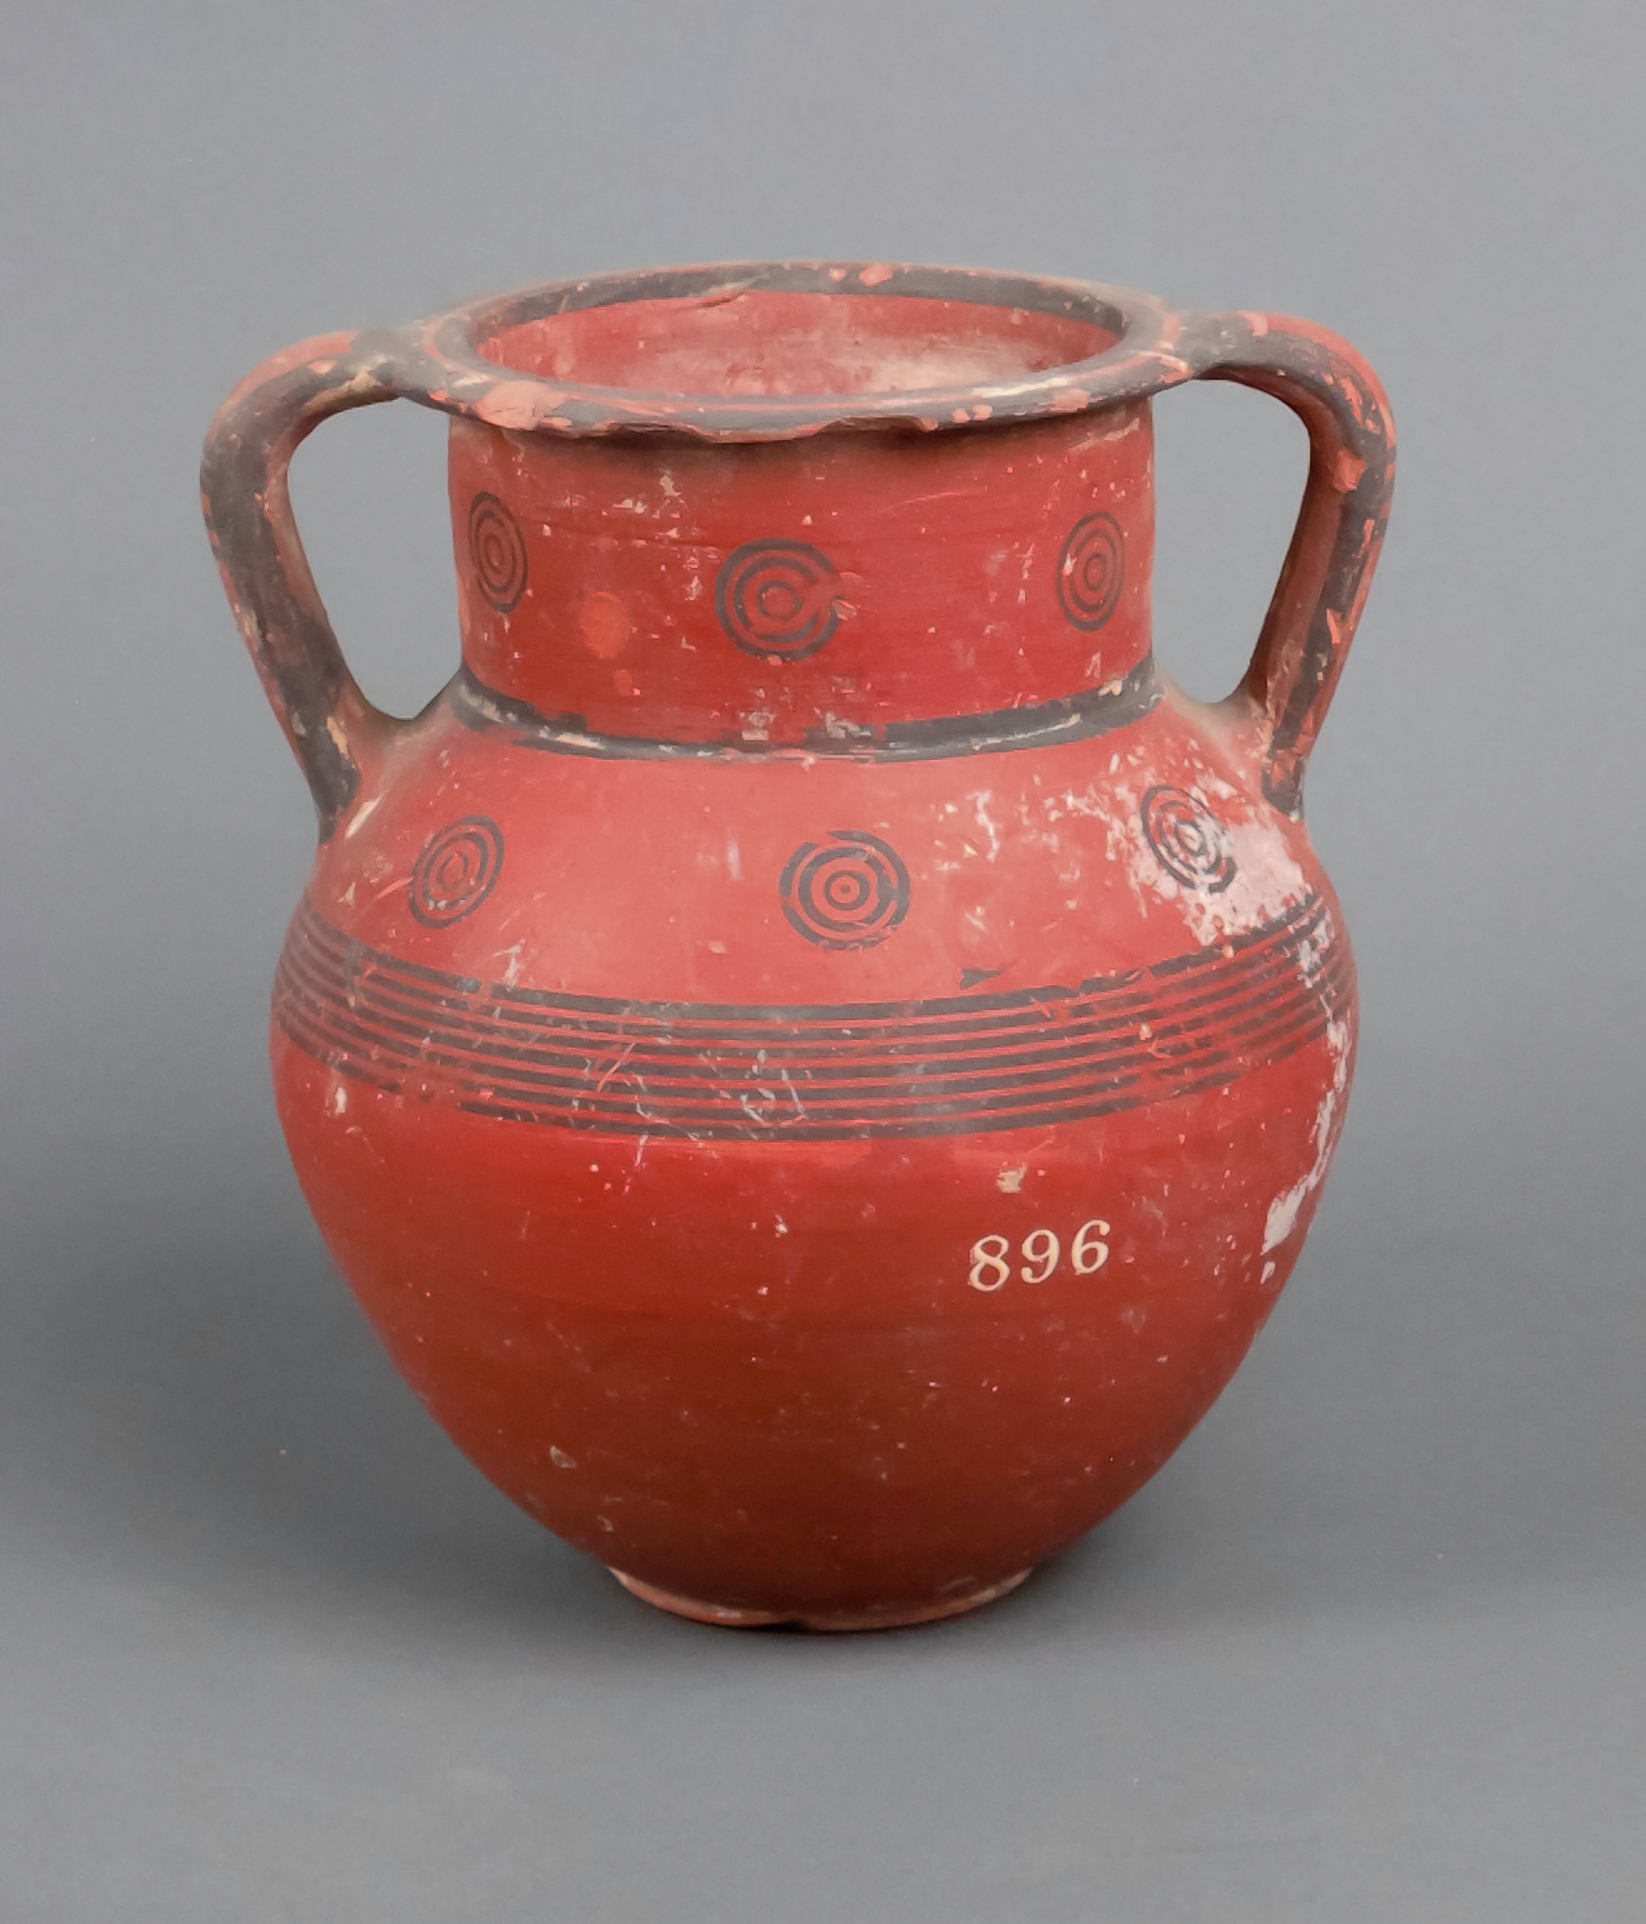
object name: amphora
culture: cypriot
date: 507-323 BCE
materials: terracotta